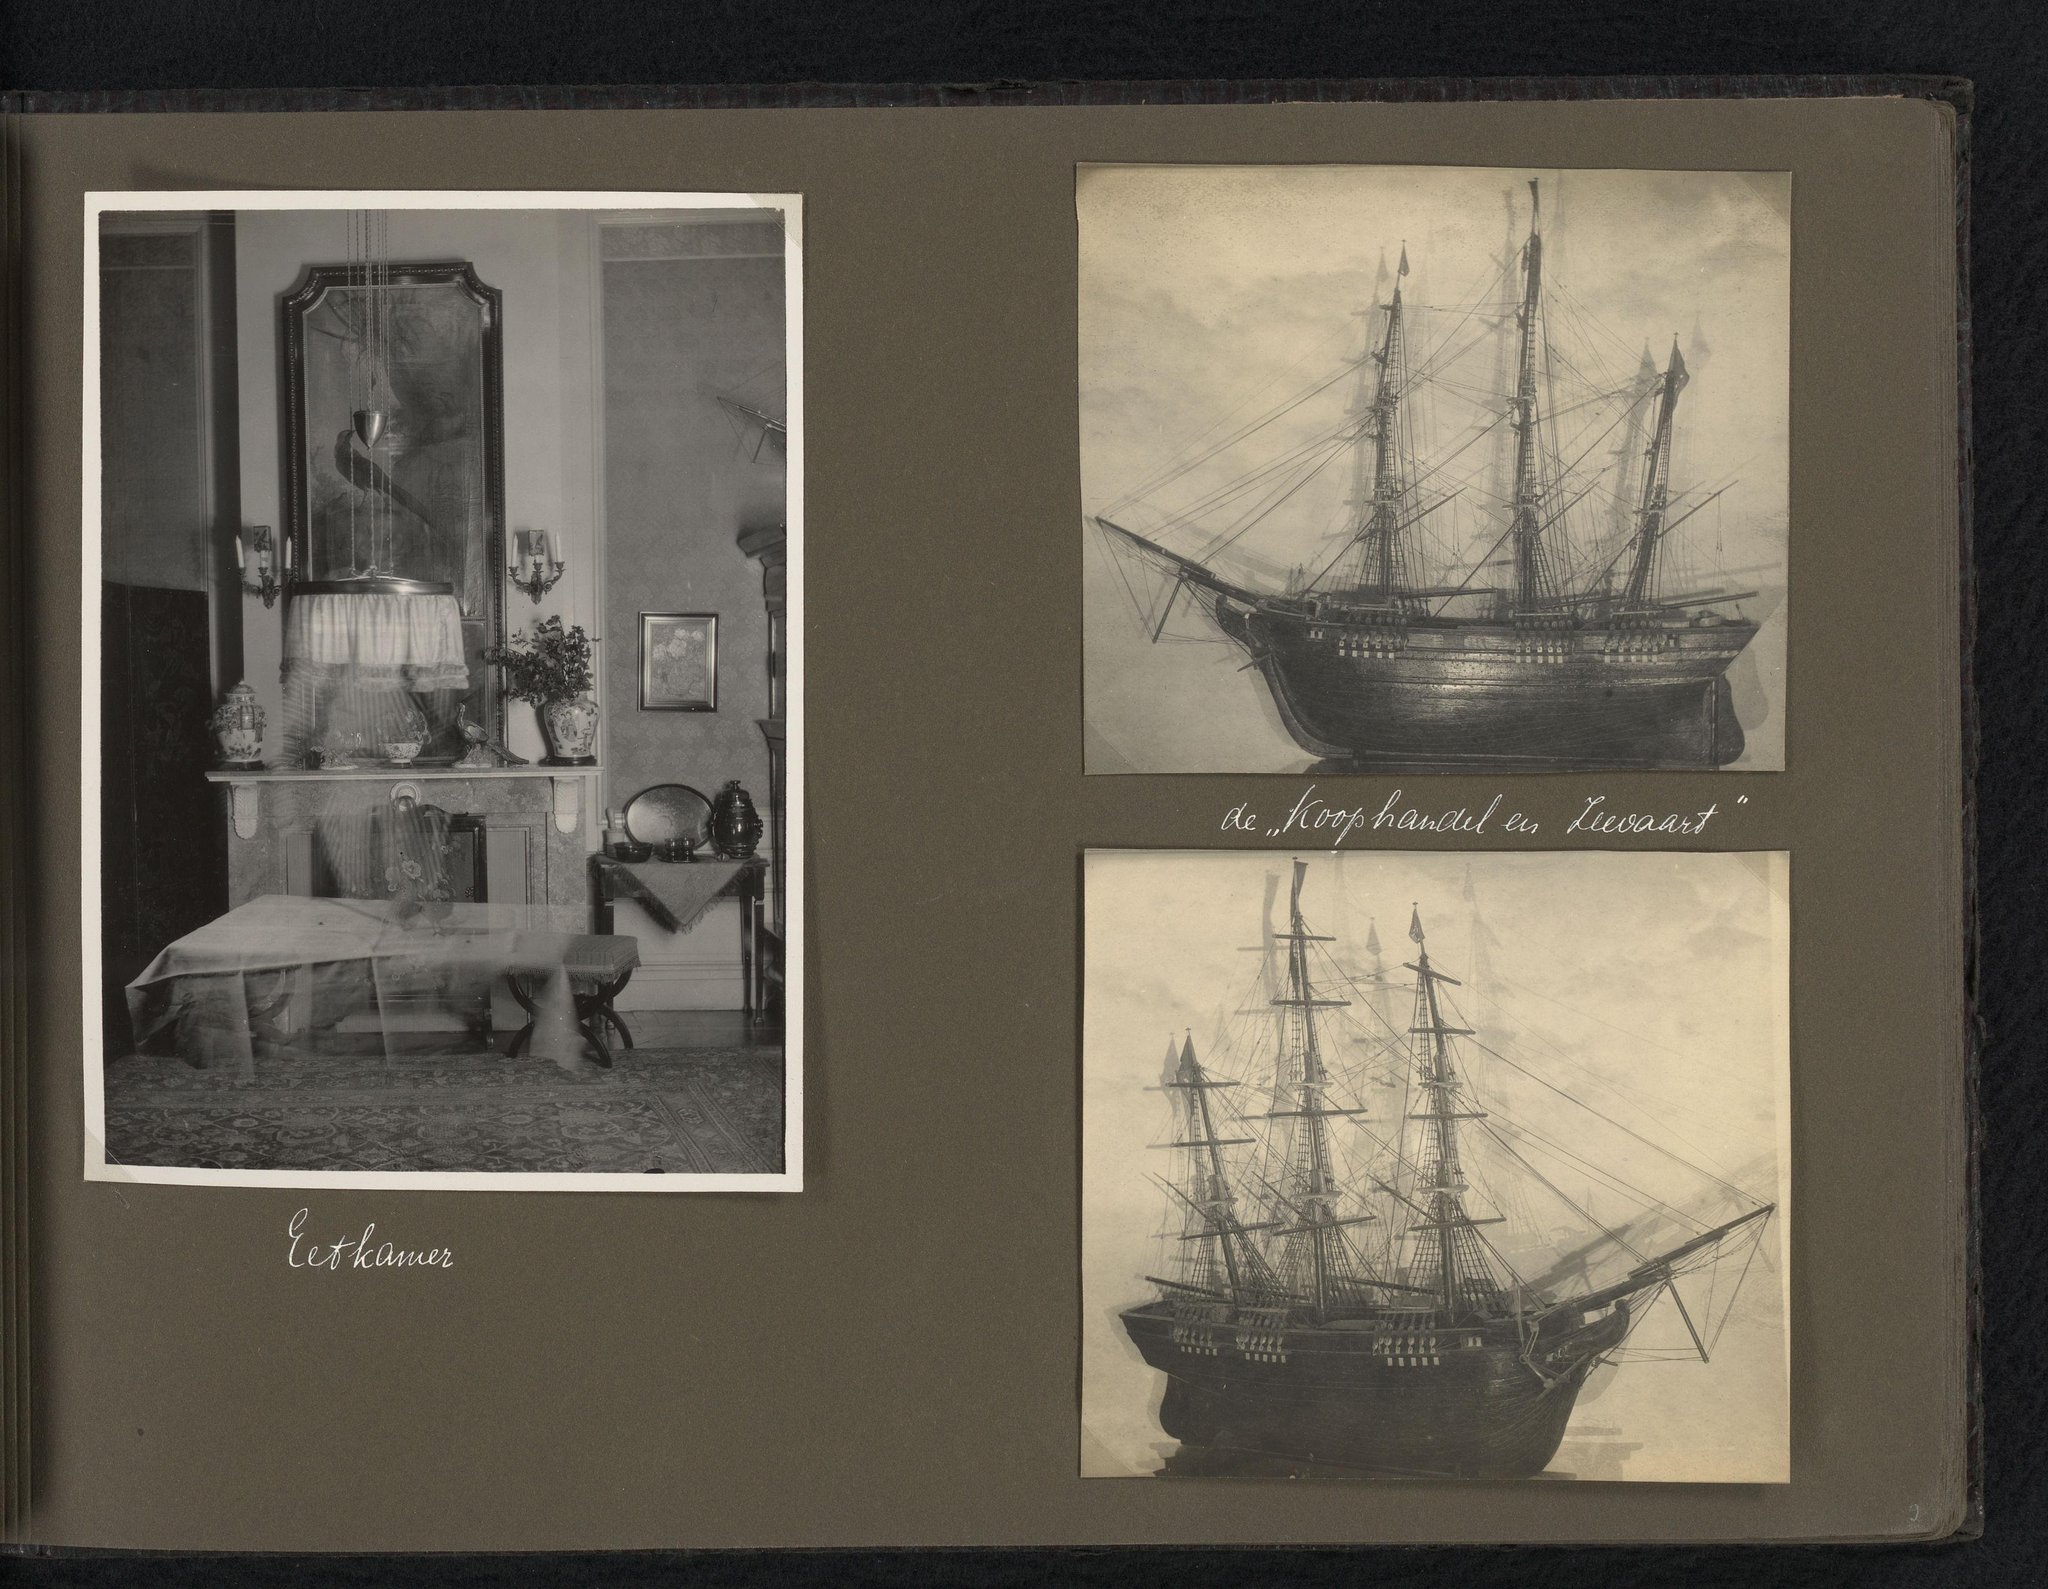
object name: photograph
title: Eetkamer van Keizersgracht 806-808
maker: frank willem van den berg (1912-1998)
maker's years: 1912-1998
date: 1930-1931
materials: paper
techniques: gelatin silver print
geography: amsterdam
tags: dining-room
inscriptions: inscription: ‘m. spiegel 2.17 x 0.96’